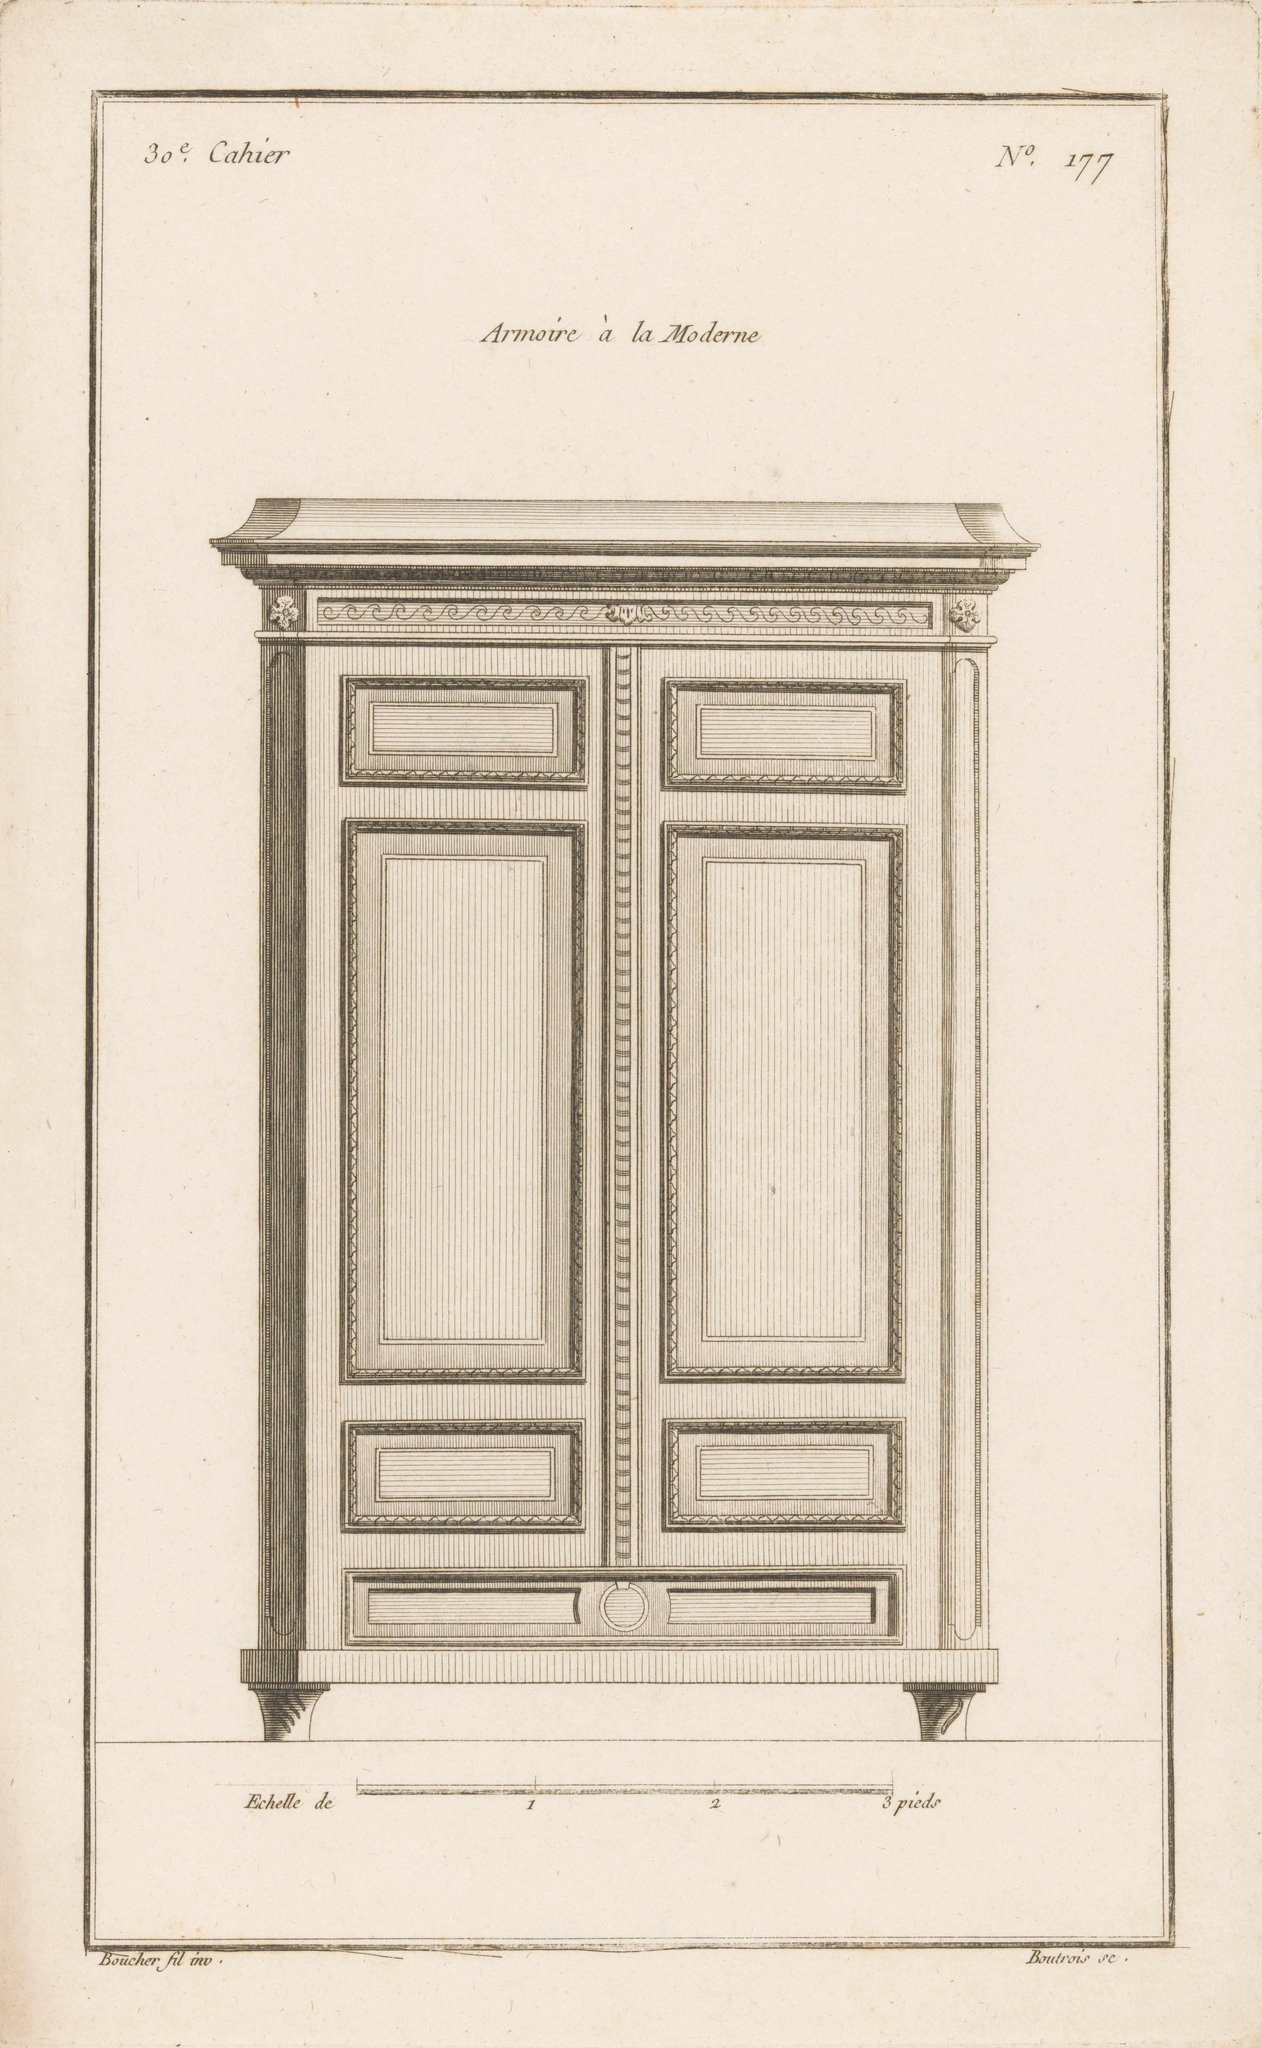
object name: ornament print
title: 30e Cahier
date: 1772-1779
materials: paper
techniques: engraving, etching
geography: paris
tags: furniture for storage, flowers ~ ornament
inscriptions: collector's mark: Lugt 2760, collector's mark: Lugt 2228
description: Kast gedecoreerd met bloemmotieven in de bovenhoeken. Prentnummer 177.